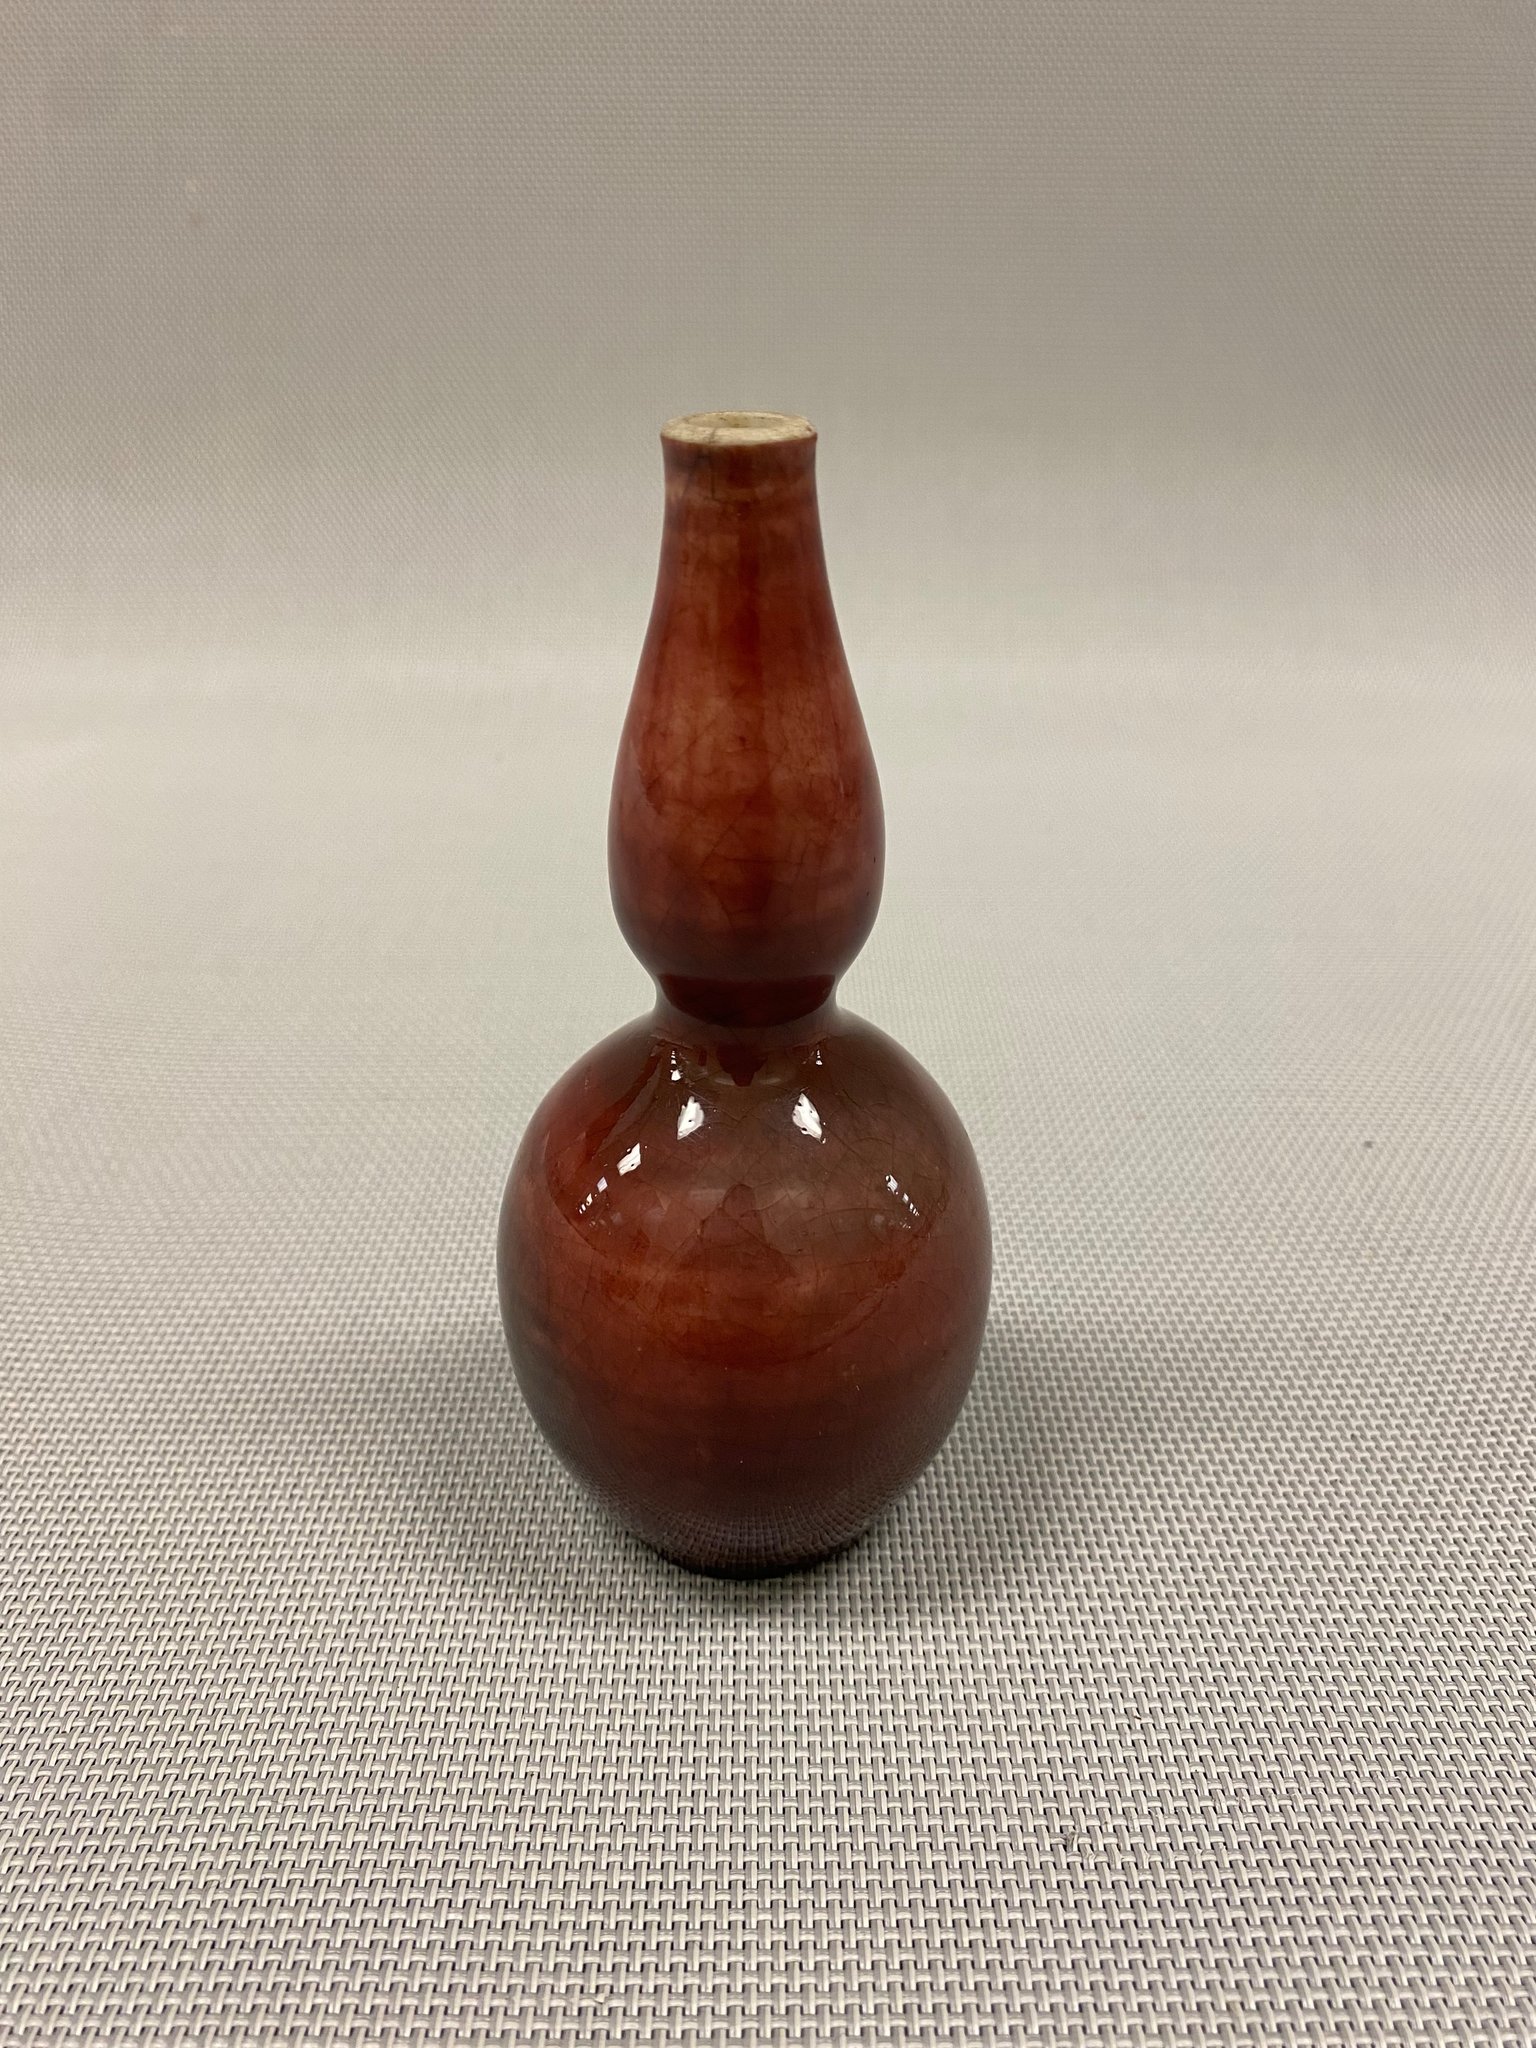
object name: vase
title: Gourd-shaped vase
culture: chinese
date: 1801-1900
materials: copper, glaze, porcelain